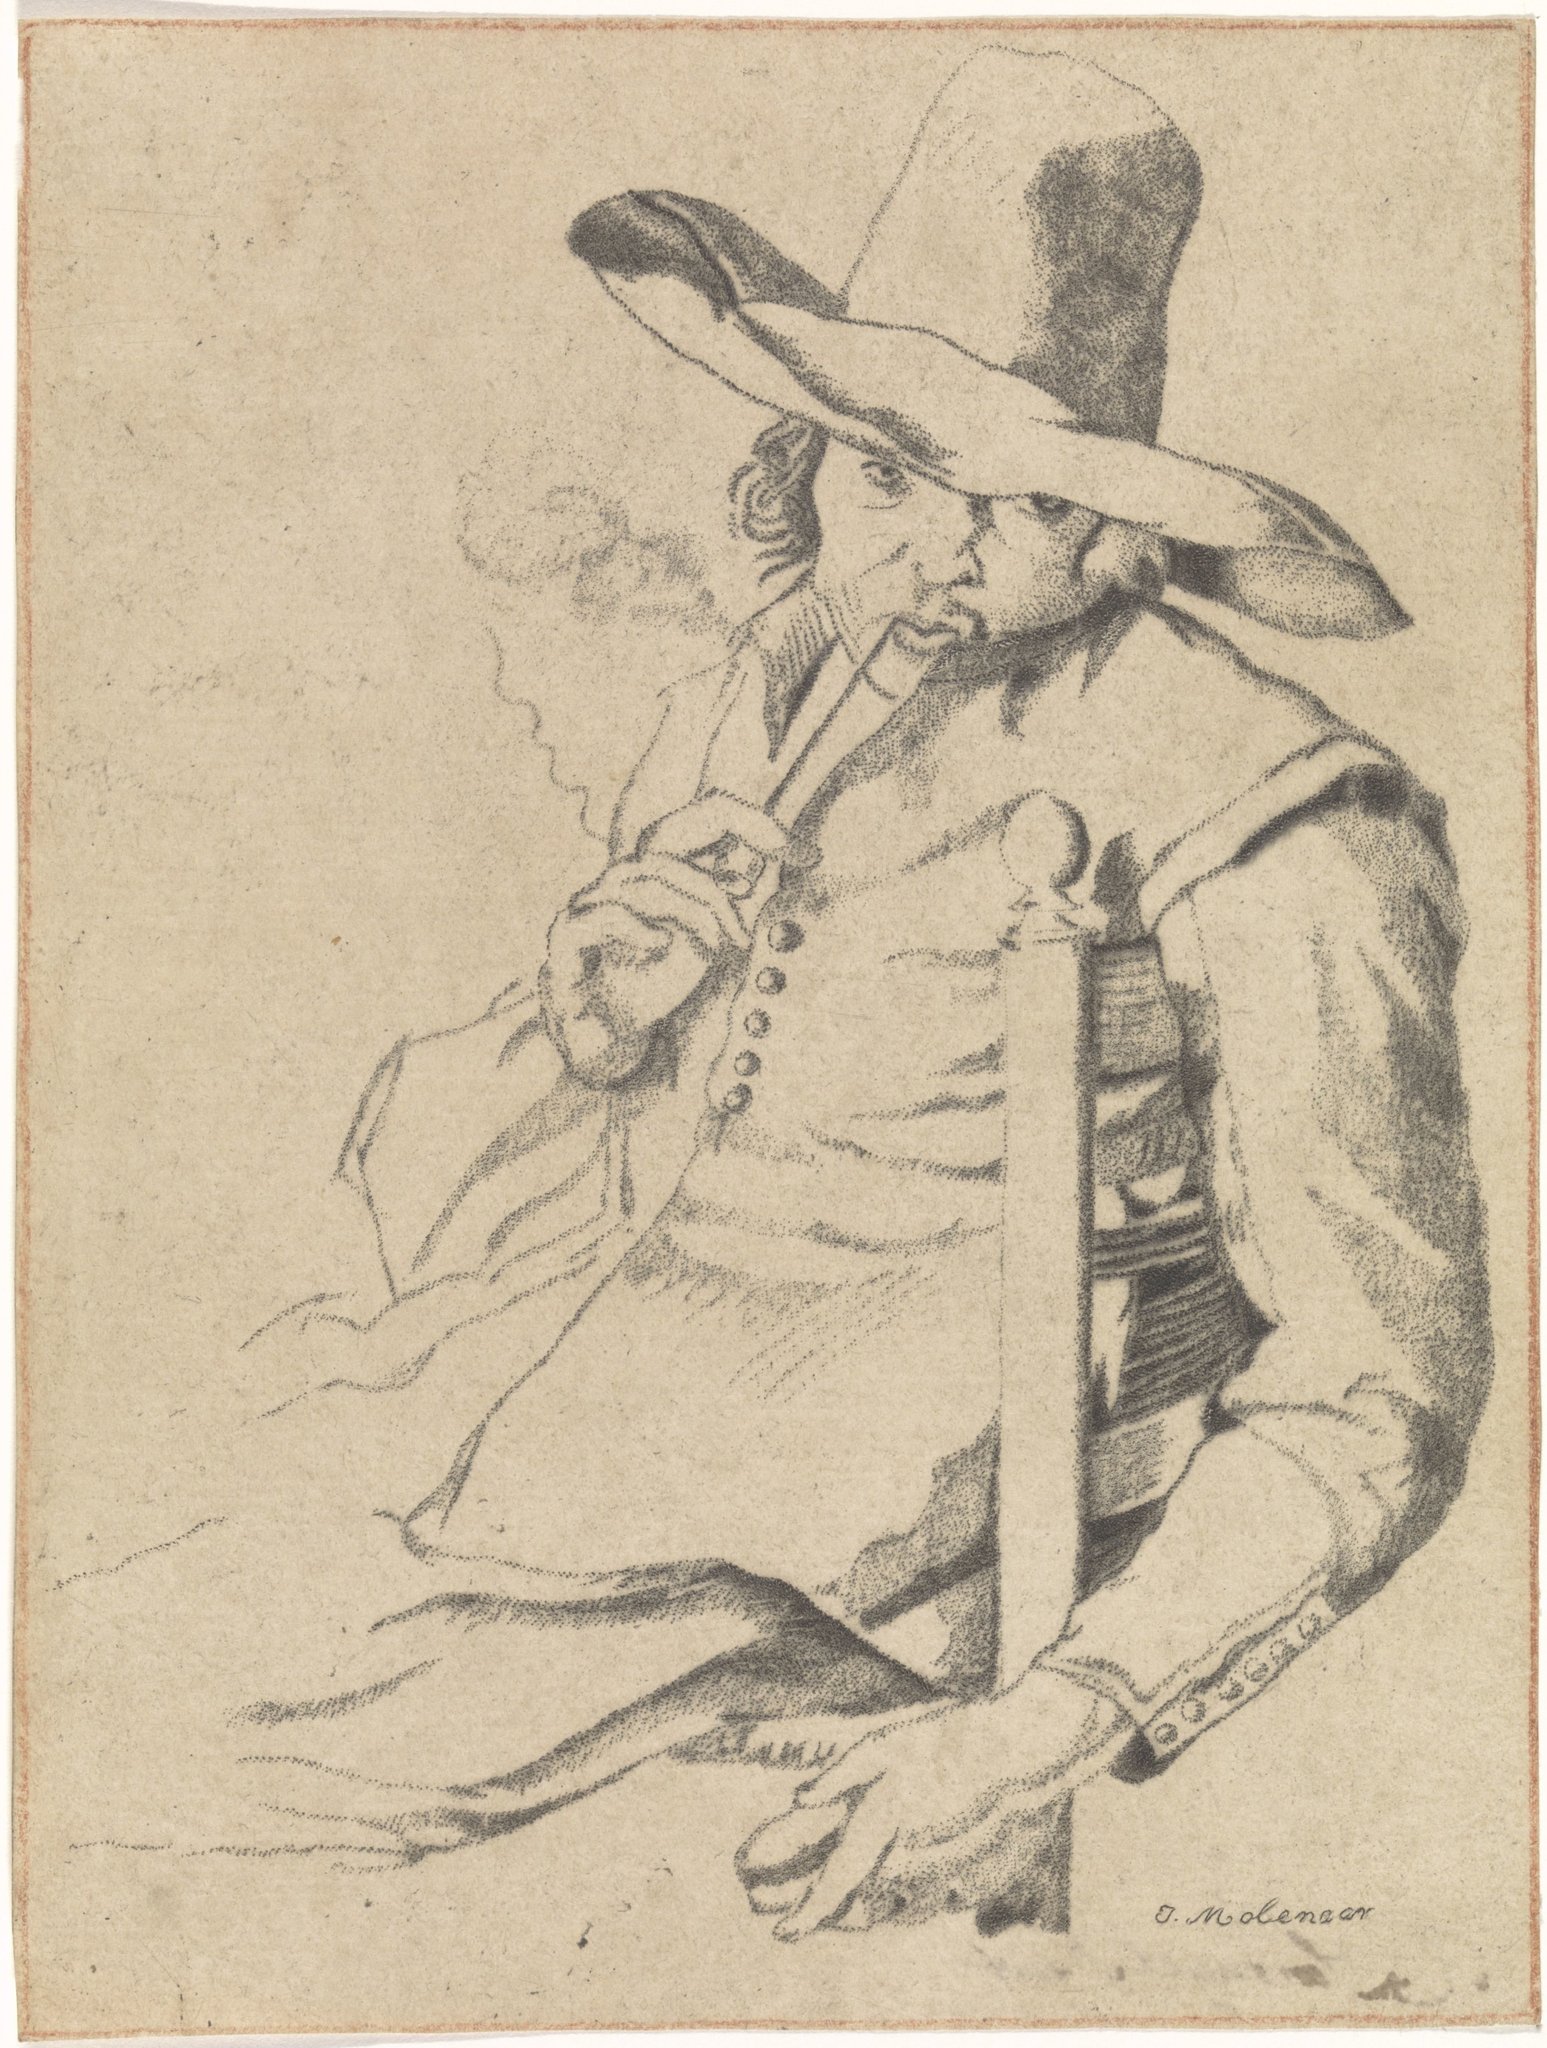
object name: print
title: Pijp rokende man met hoge hoed op een stoel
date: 1741-1812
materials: chalk, paper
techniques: intaglio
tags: pipe ~ tobacco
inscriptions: collector's mark: Lugt 2228, inscription: ‘R Sondag Fecit’